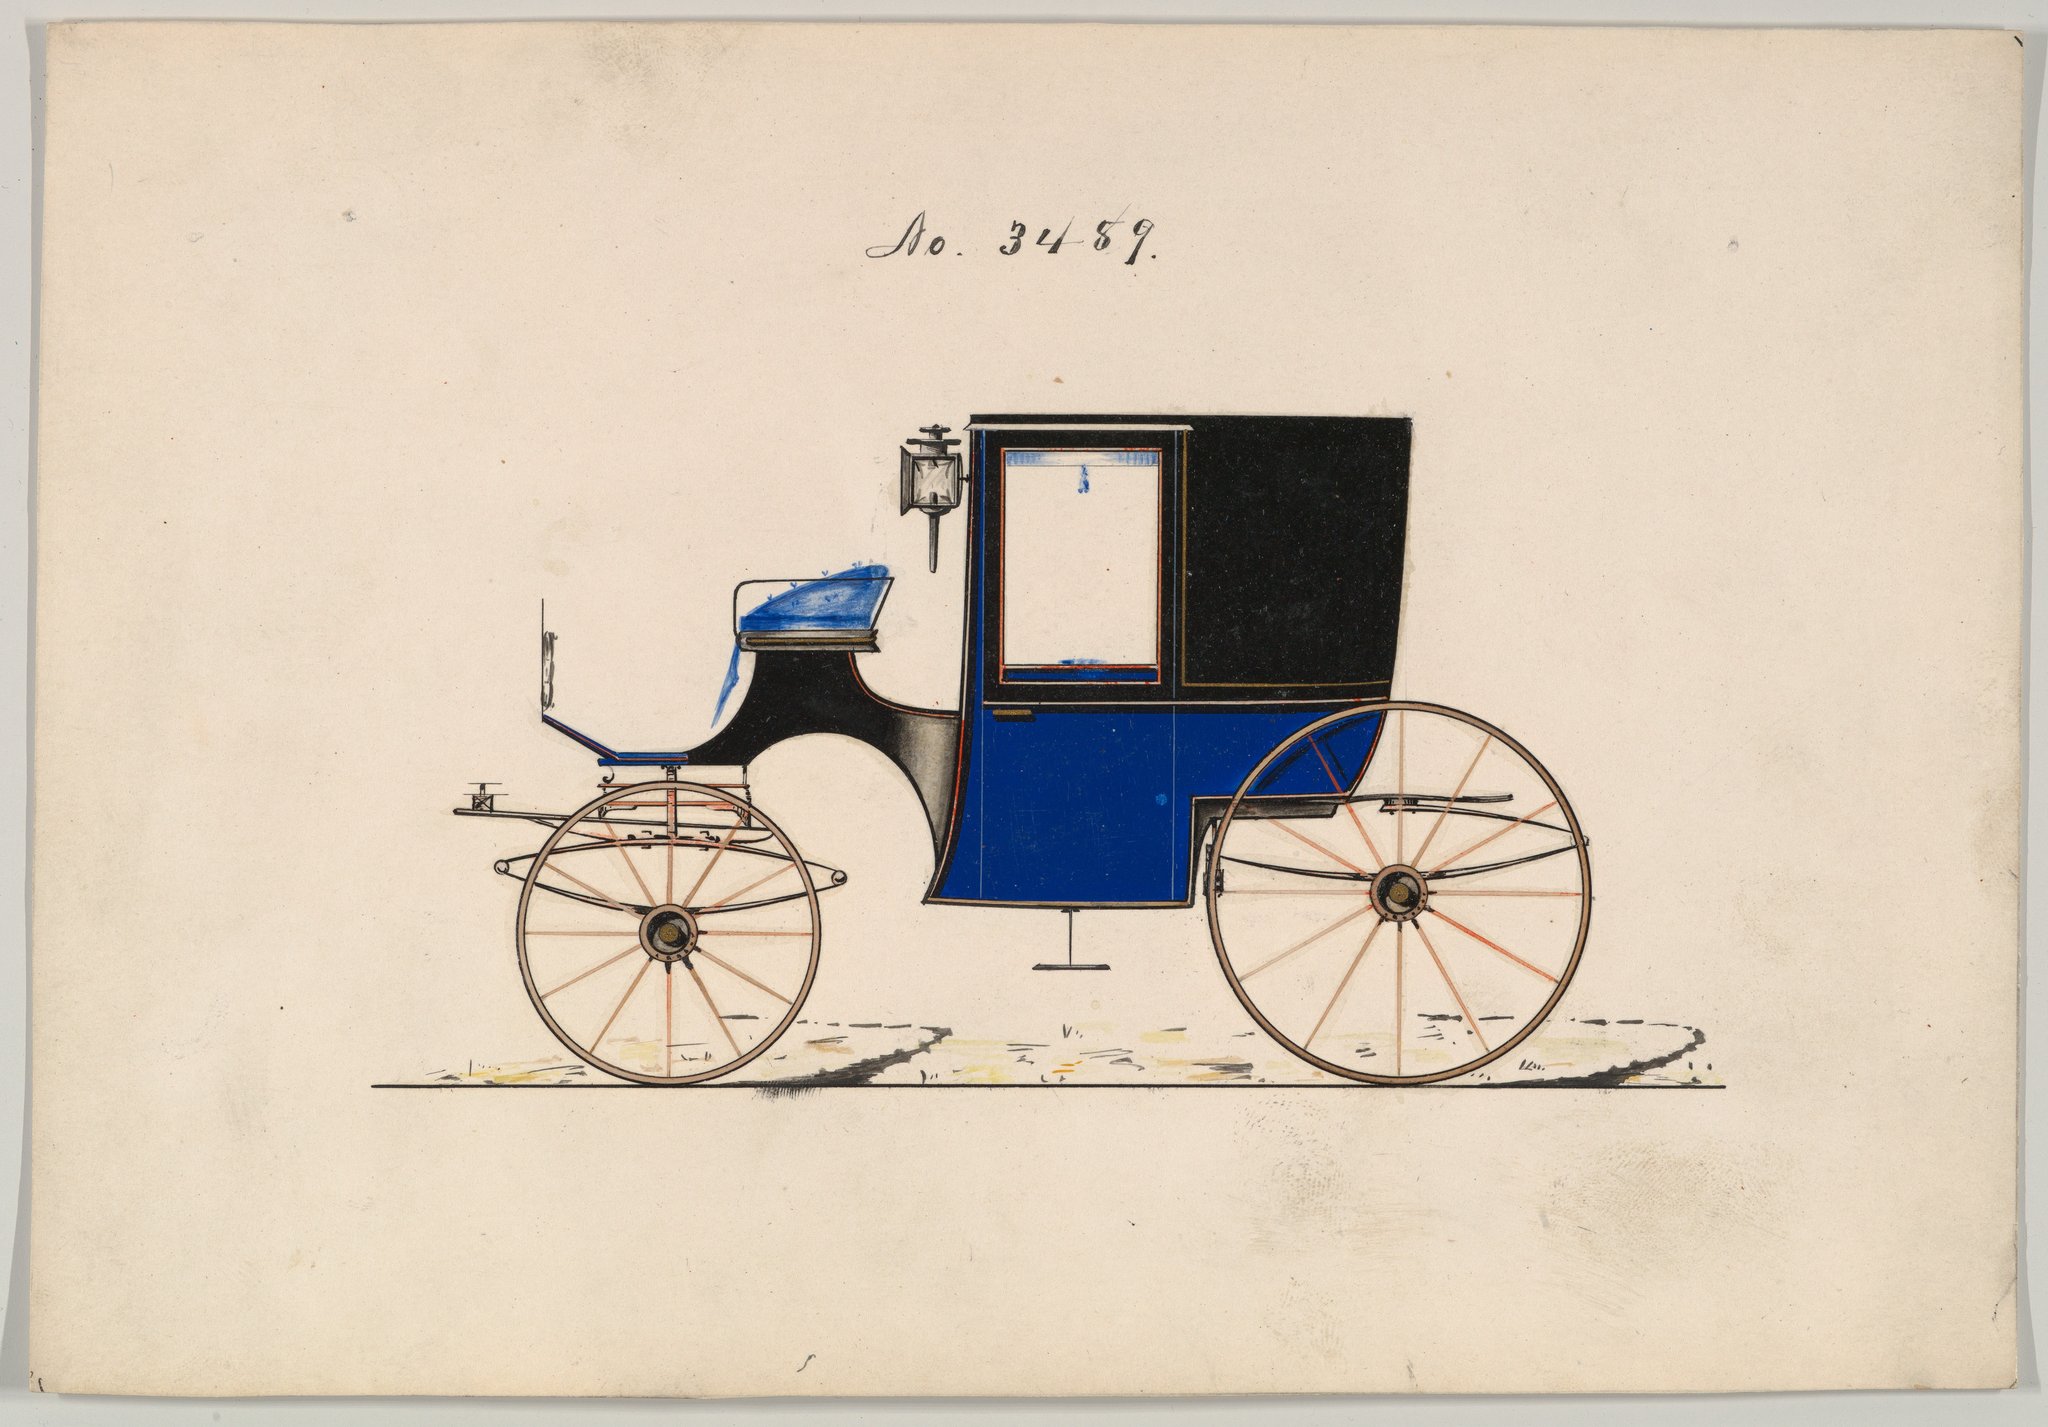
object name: drawing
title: Brougham #3489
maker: brewster & co.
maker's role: manufacturer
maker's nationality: american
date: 1879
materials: gouache, gum arabic, ink, watercolor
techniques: pen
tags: carriages